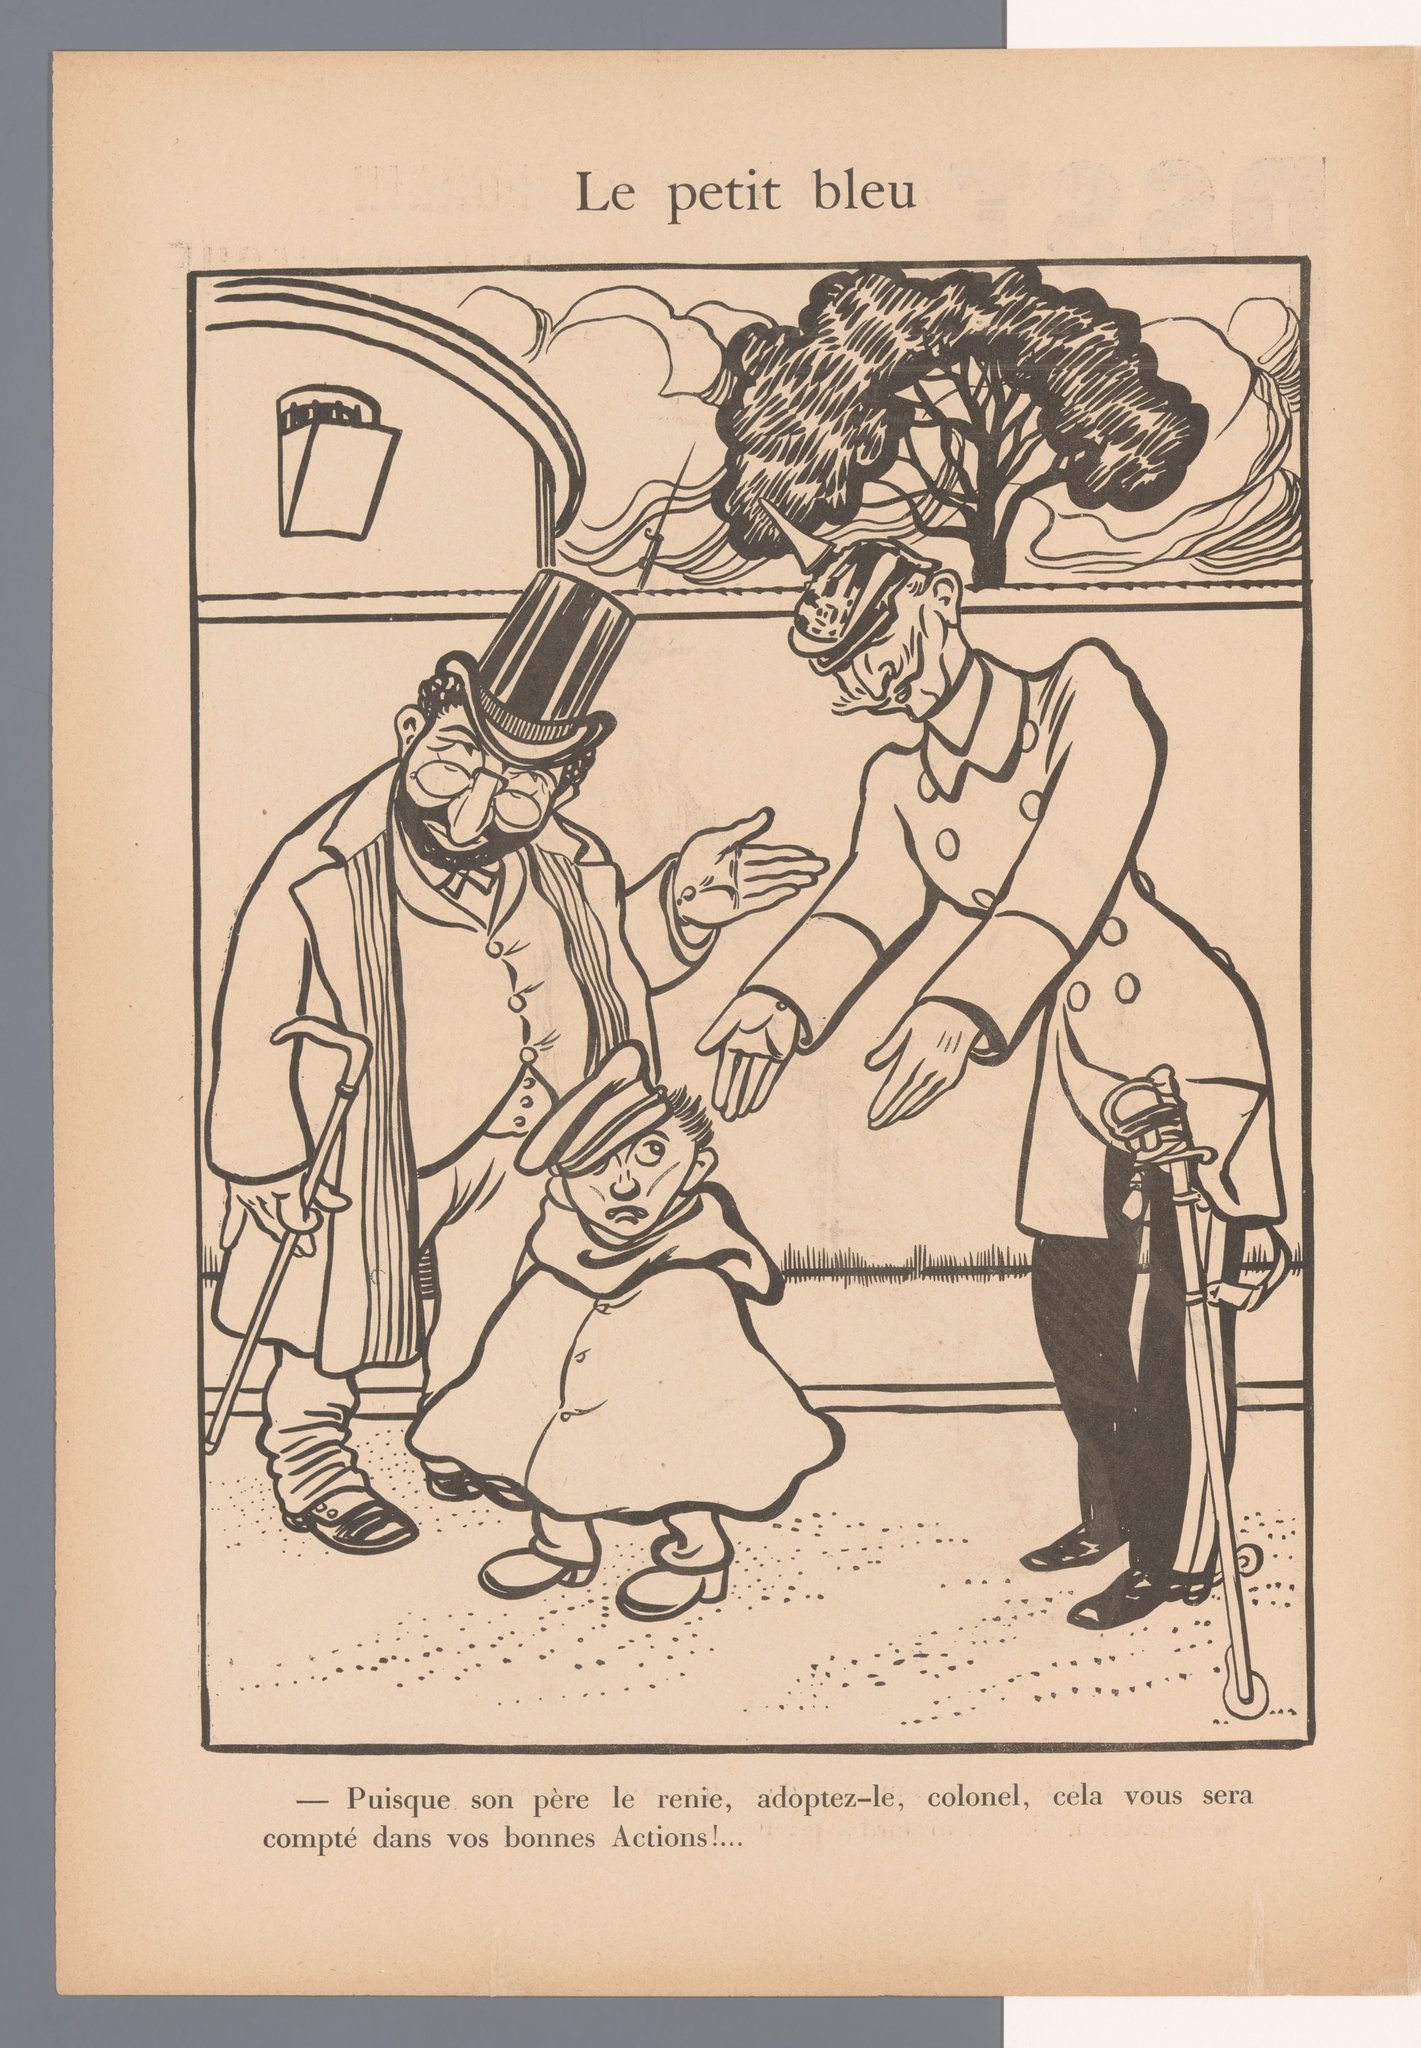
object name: leaflet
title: Le petit bleu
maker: caran dache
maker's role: draughtsman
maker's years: 1859-1909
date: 1898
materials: paper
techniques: lithograph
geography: paris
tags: georges picquart, adoption (of a child), boy (child between toddler and youth), historical persons, political caricatures and satires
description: Prent gebruikt voor: Psst...!, nr. 35, 1 oktober 1898. Psst..! was een politieke weekkrant met antisemitische en anti-Dreyfus cartoons.